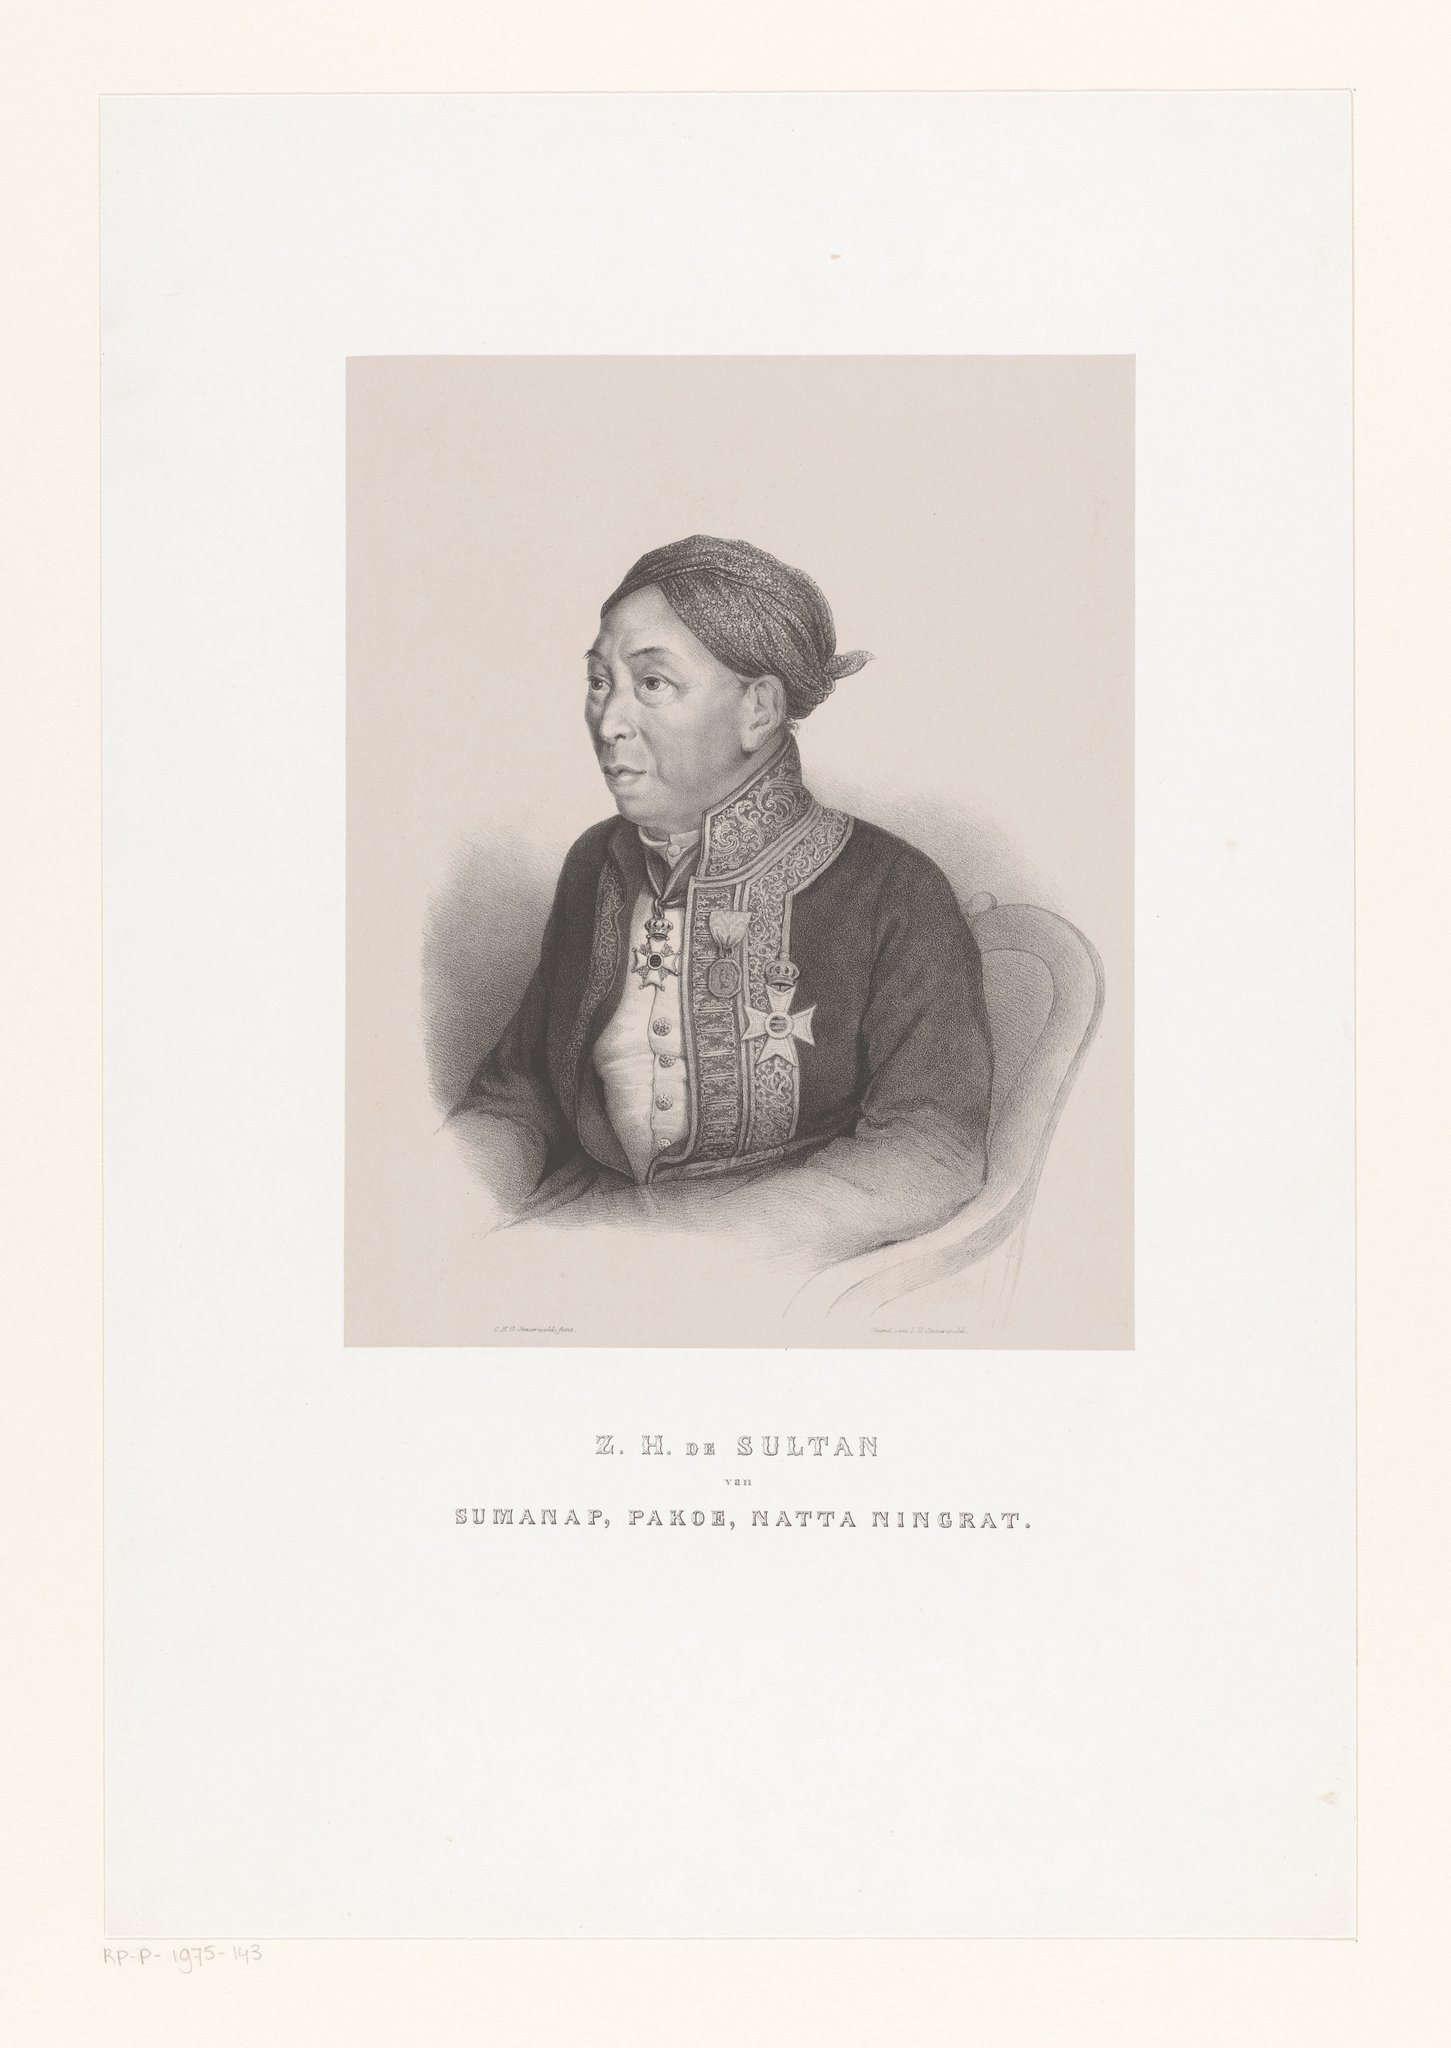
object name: print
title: Z.H. de Sultan van Sumanap, Pakoe, Natta Ningrat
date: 1822-1863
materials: paper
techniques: lithograph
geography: dordrecht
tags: historical persons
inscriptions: inscription: ‘4a / 10-9-'75’, collector's mark: Lugt 2228